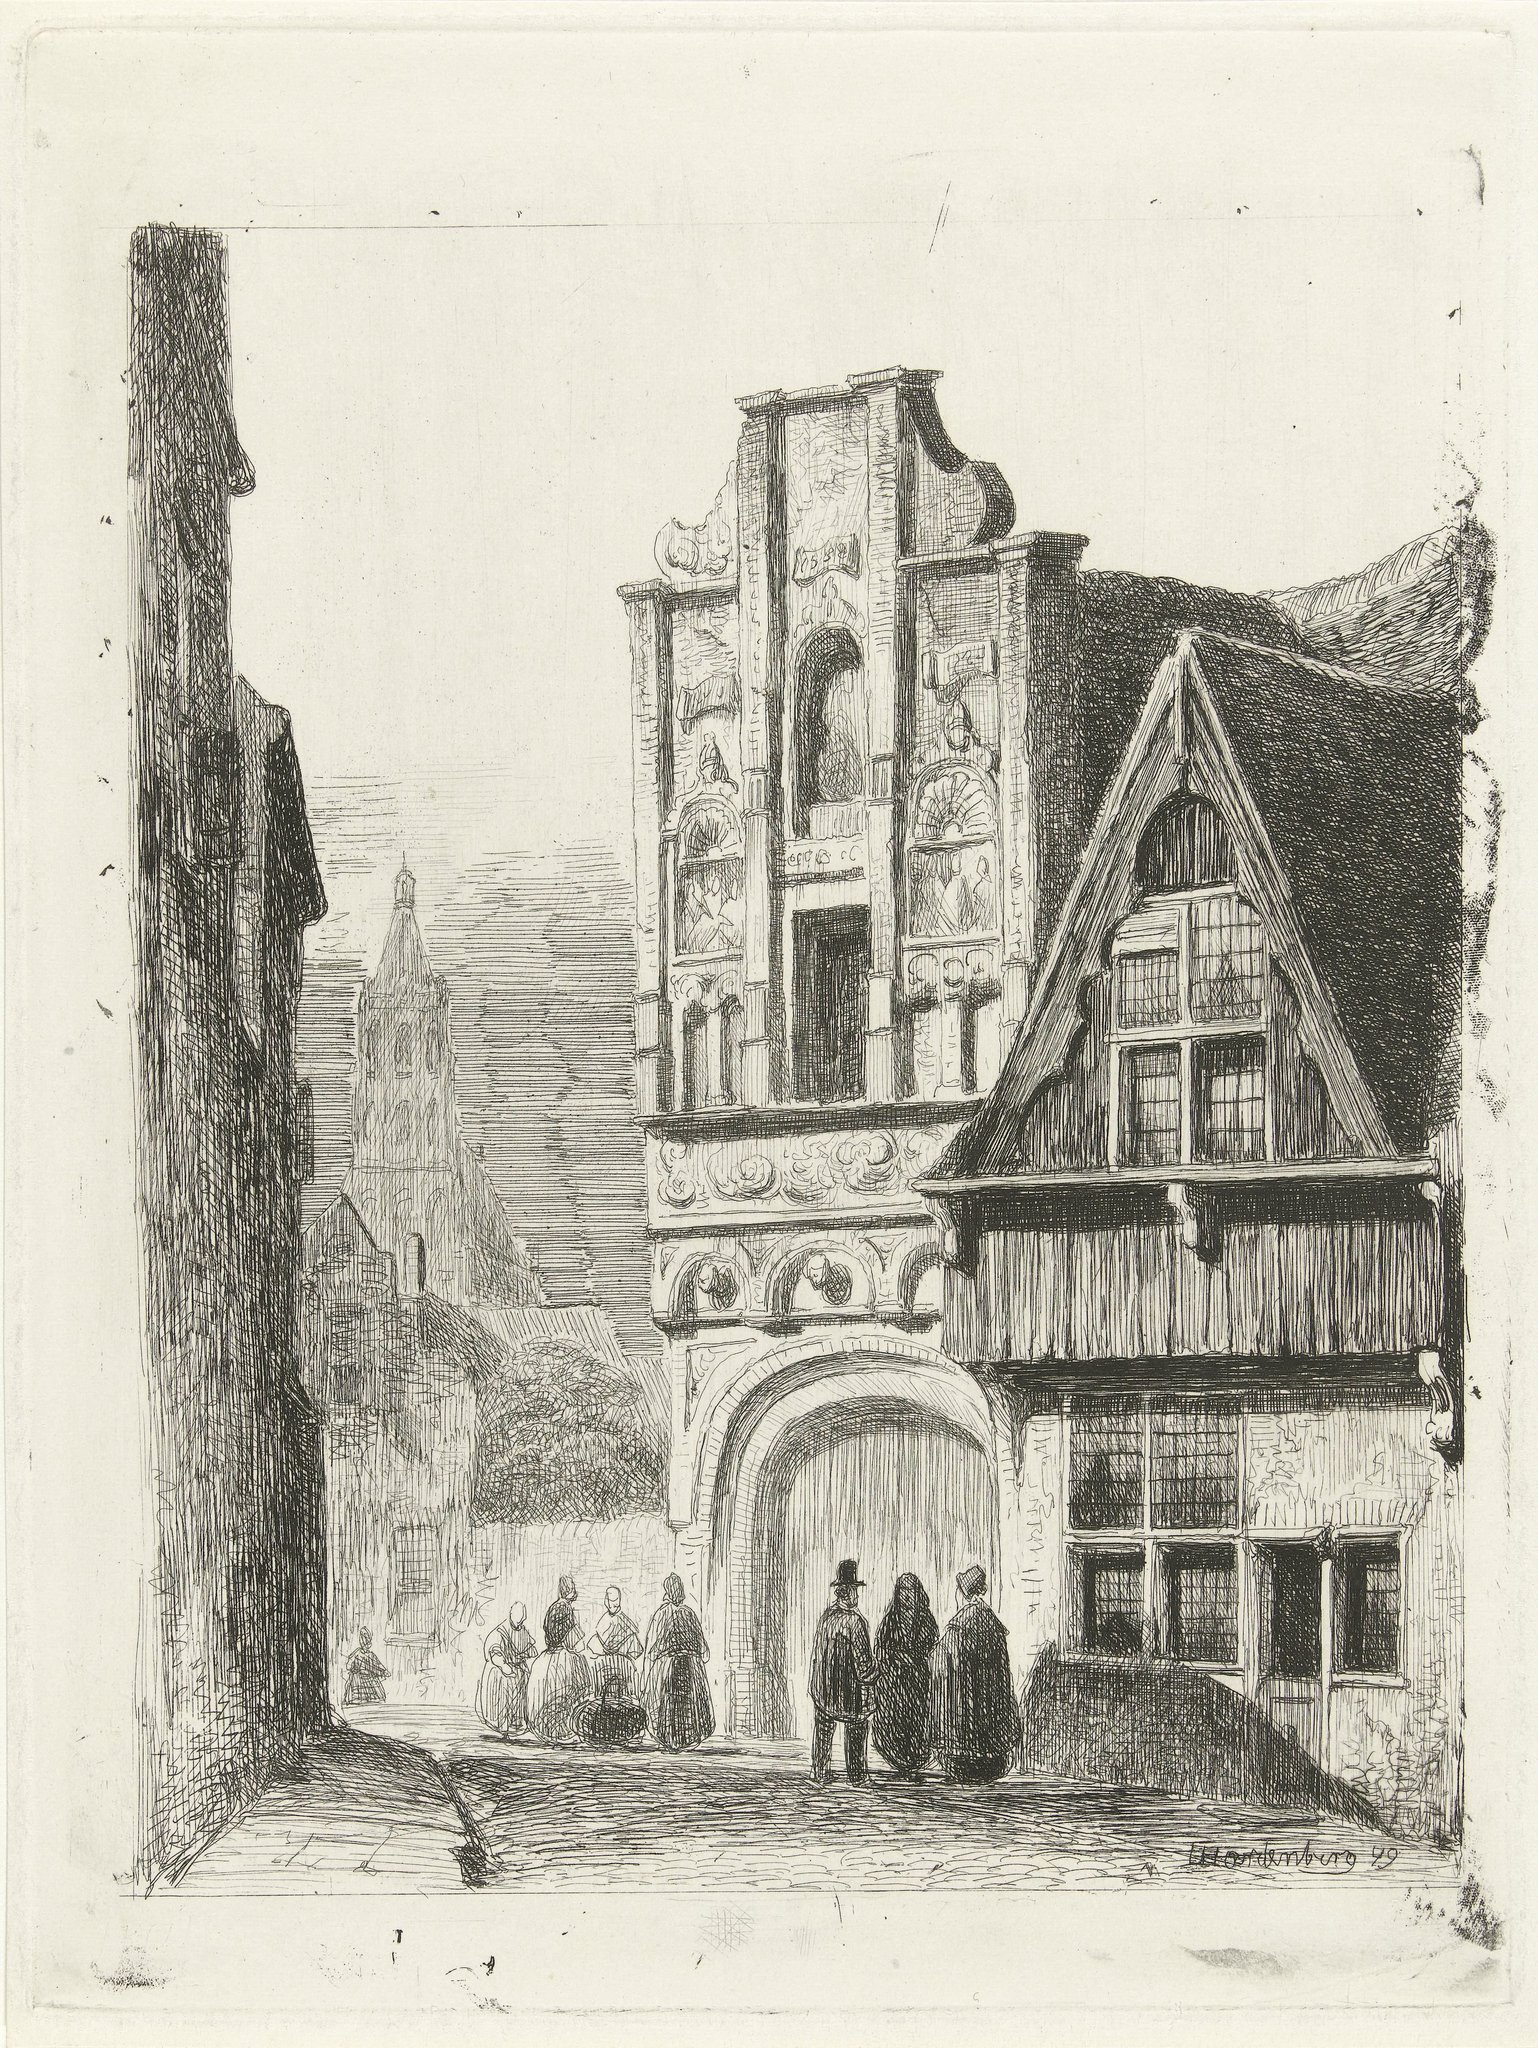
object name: print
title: Figuren bij een Renaissance gevel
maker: lambertus hardenberg (1822-1900)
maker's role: draughtsman, painter, print maker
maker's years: 1822-1900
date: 1879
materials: paper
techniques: etching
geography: the hague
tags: village street (+ city(-scape) with figures, staffage), parts of church exterior and annexes: tower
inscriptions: collector's mark: Lugt 2228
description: Converserende figuren bij een gebouw met een Renaissance gevel, een kerktoren op de achtergrond.